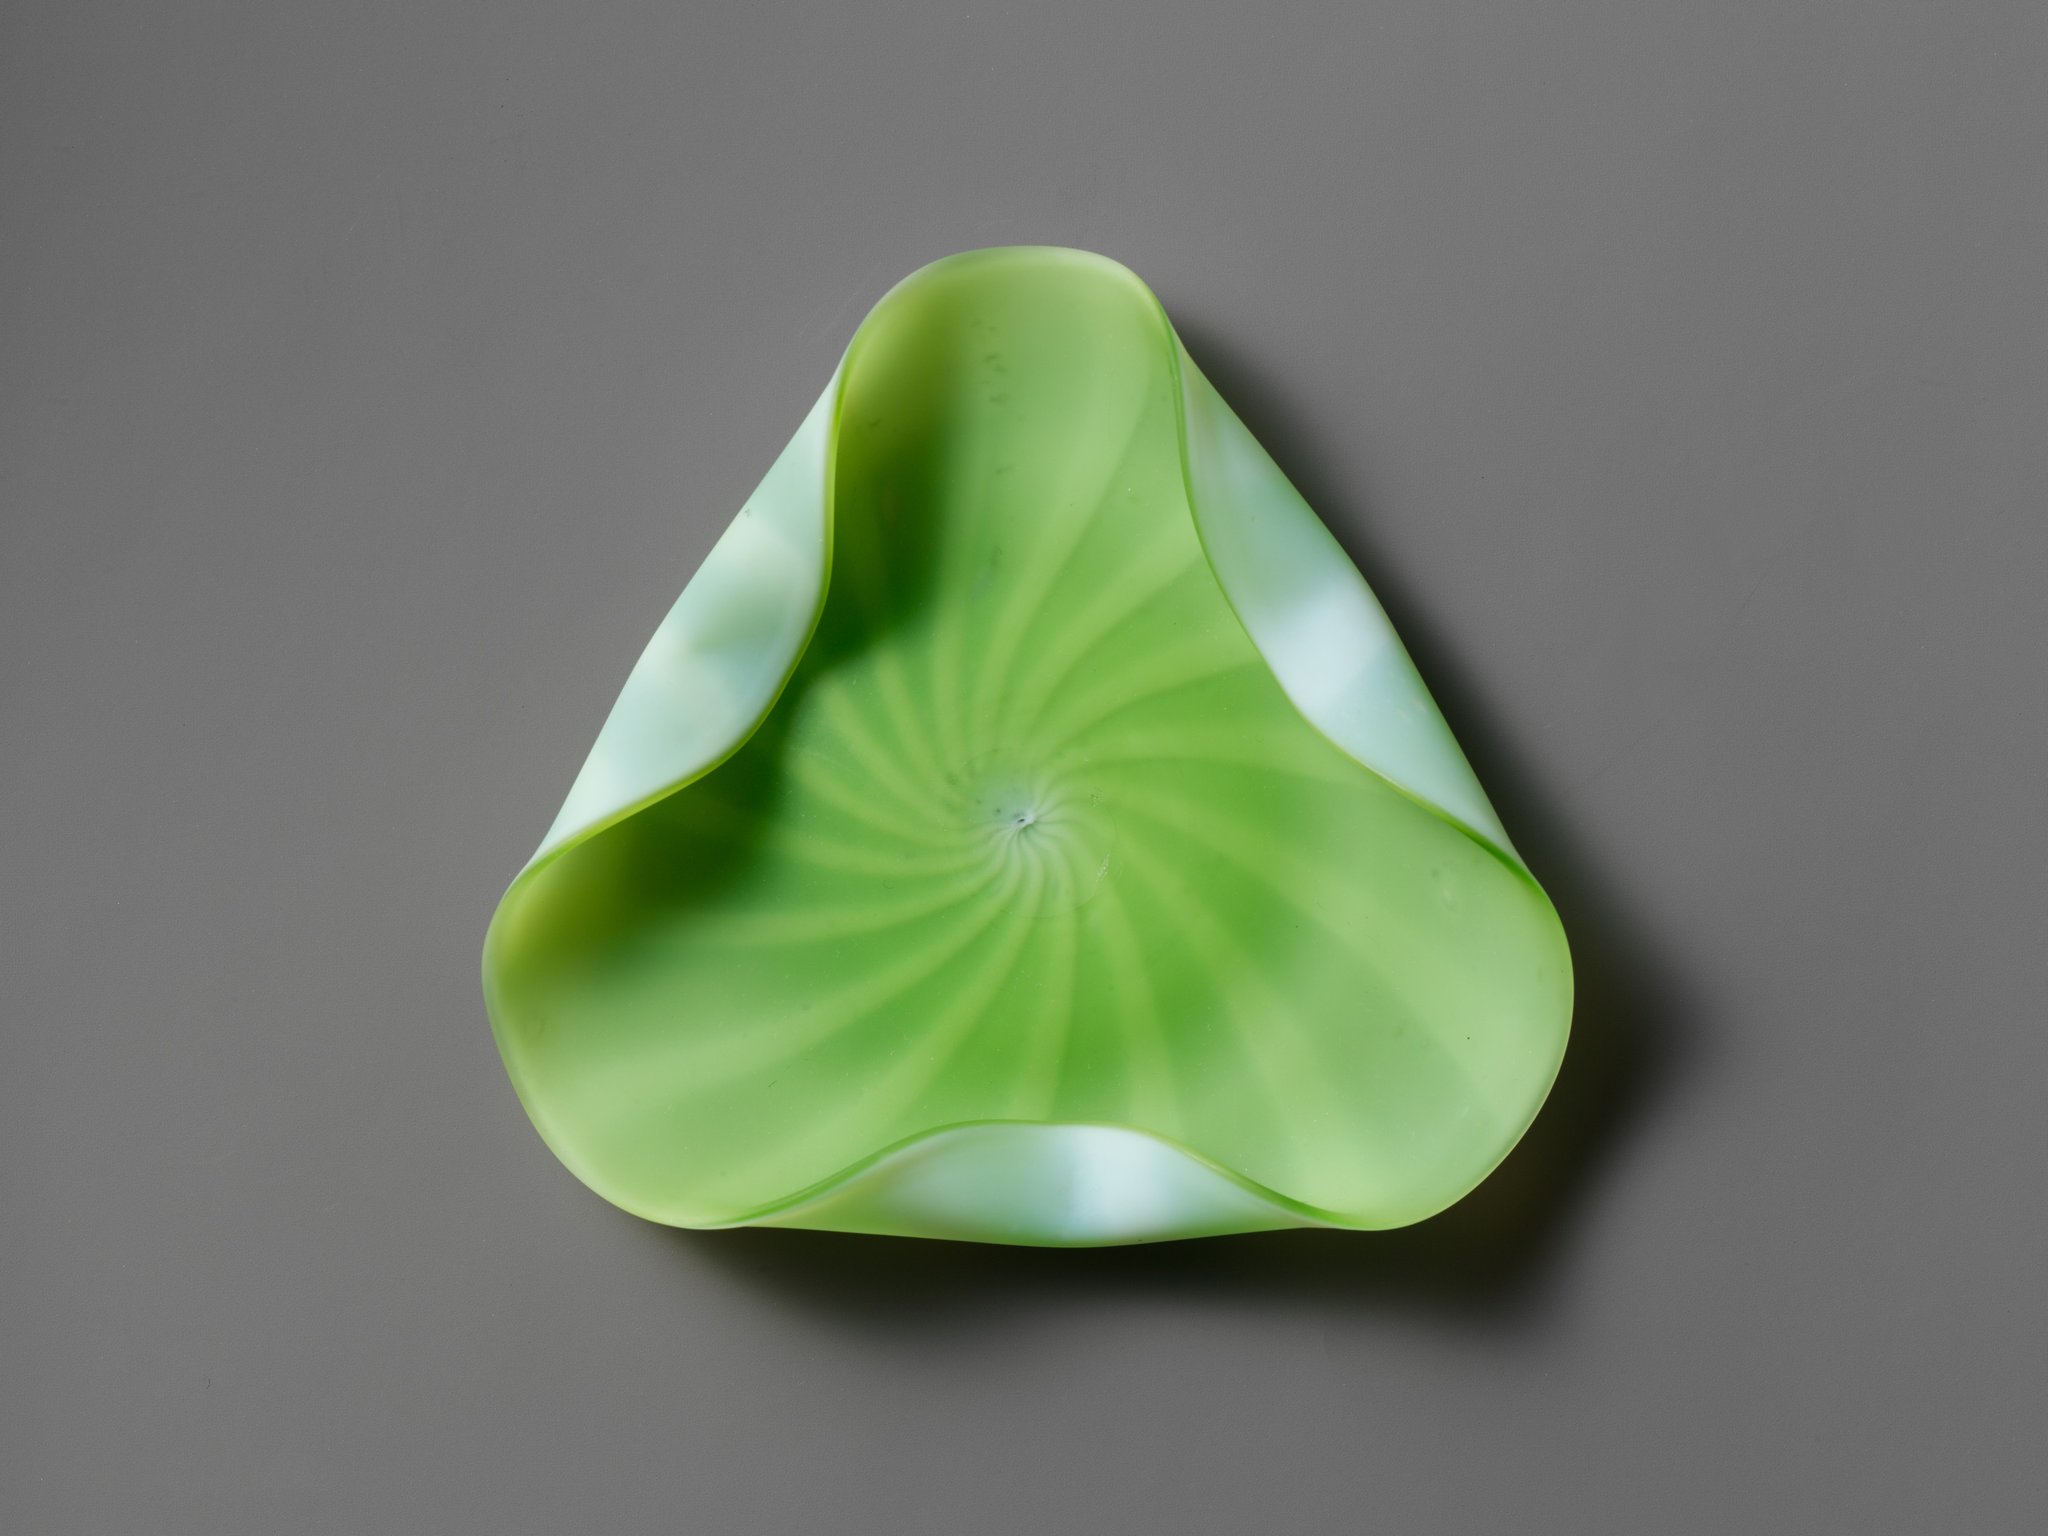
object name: plate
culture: british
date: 1885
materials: glass, textile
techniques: glassblowing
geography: england